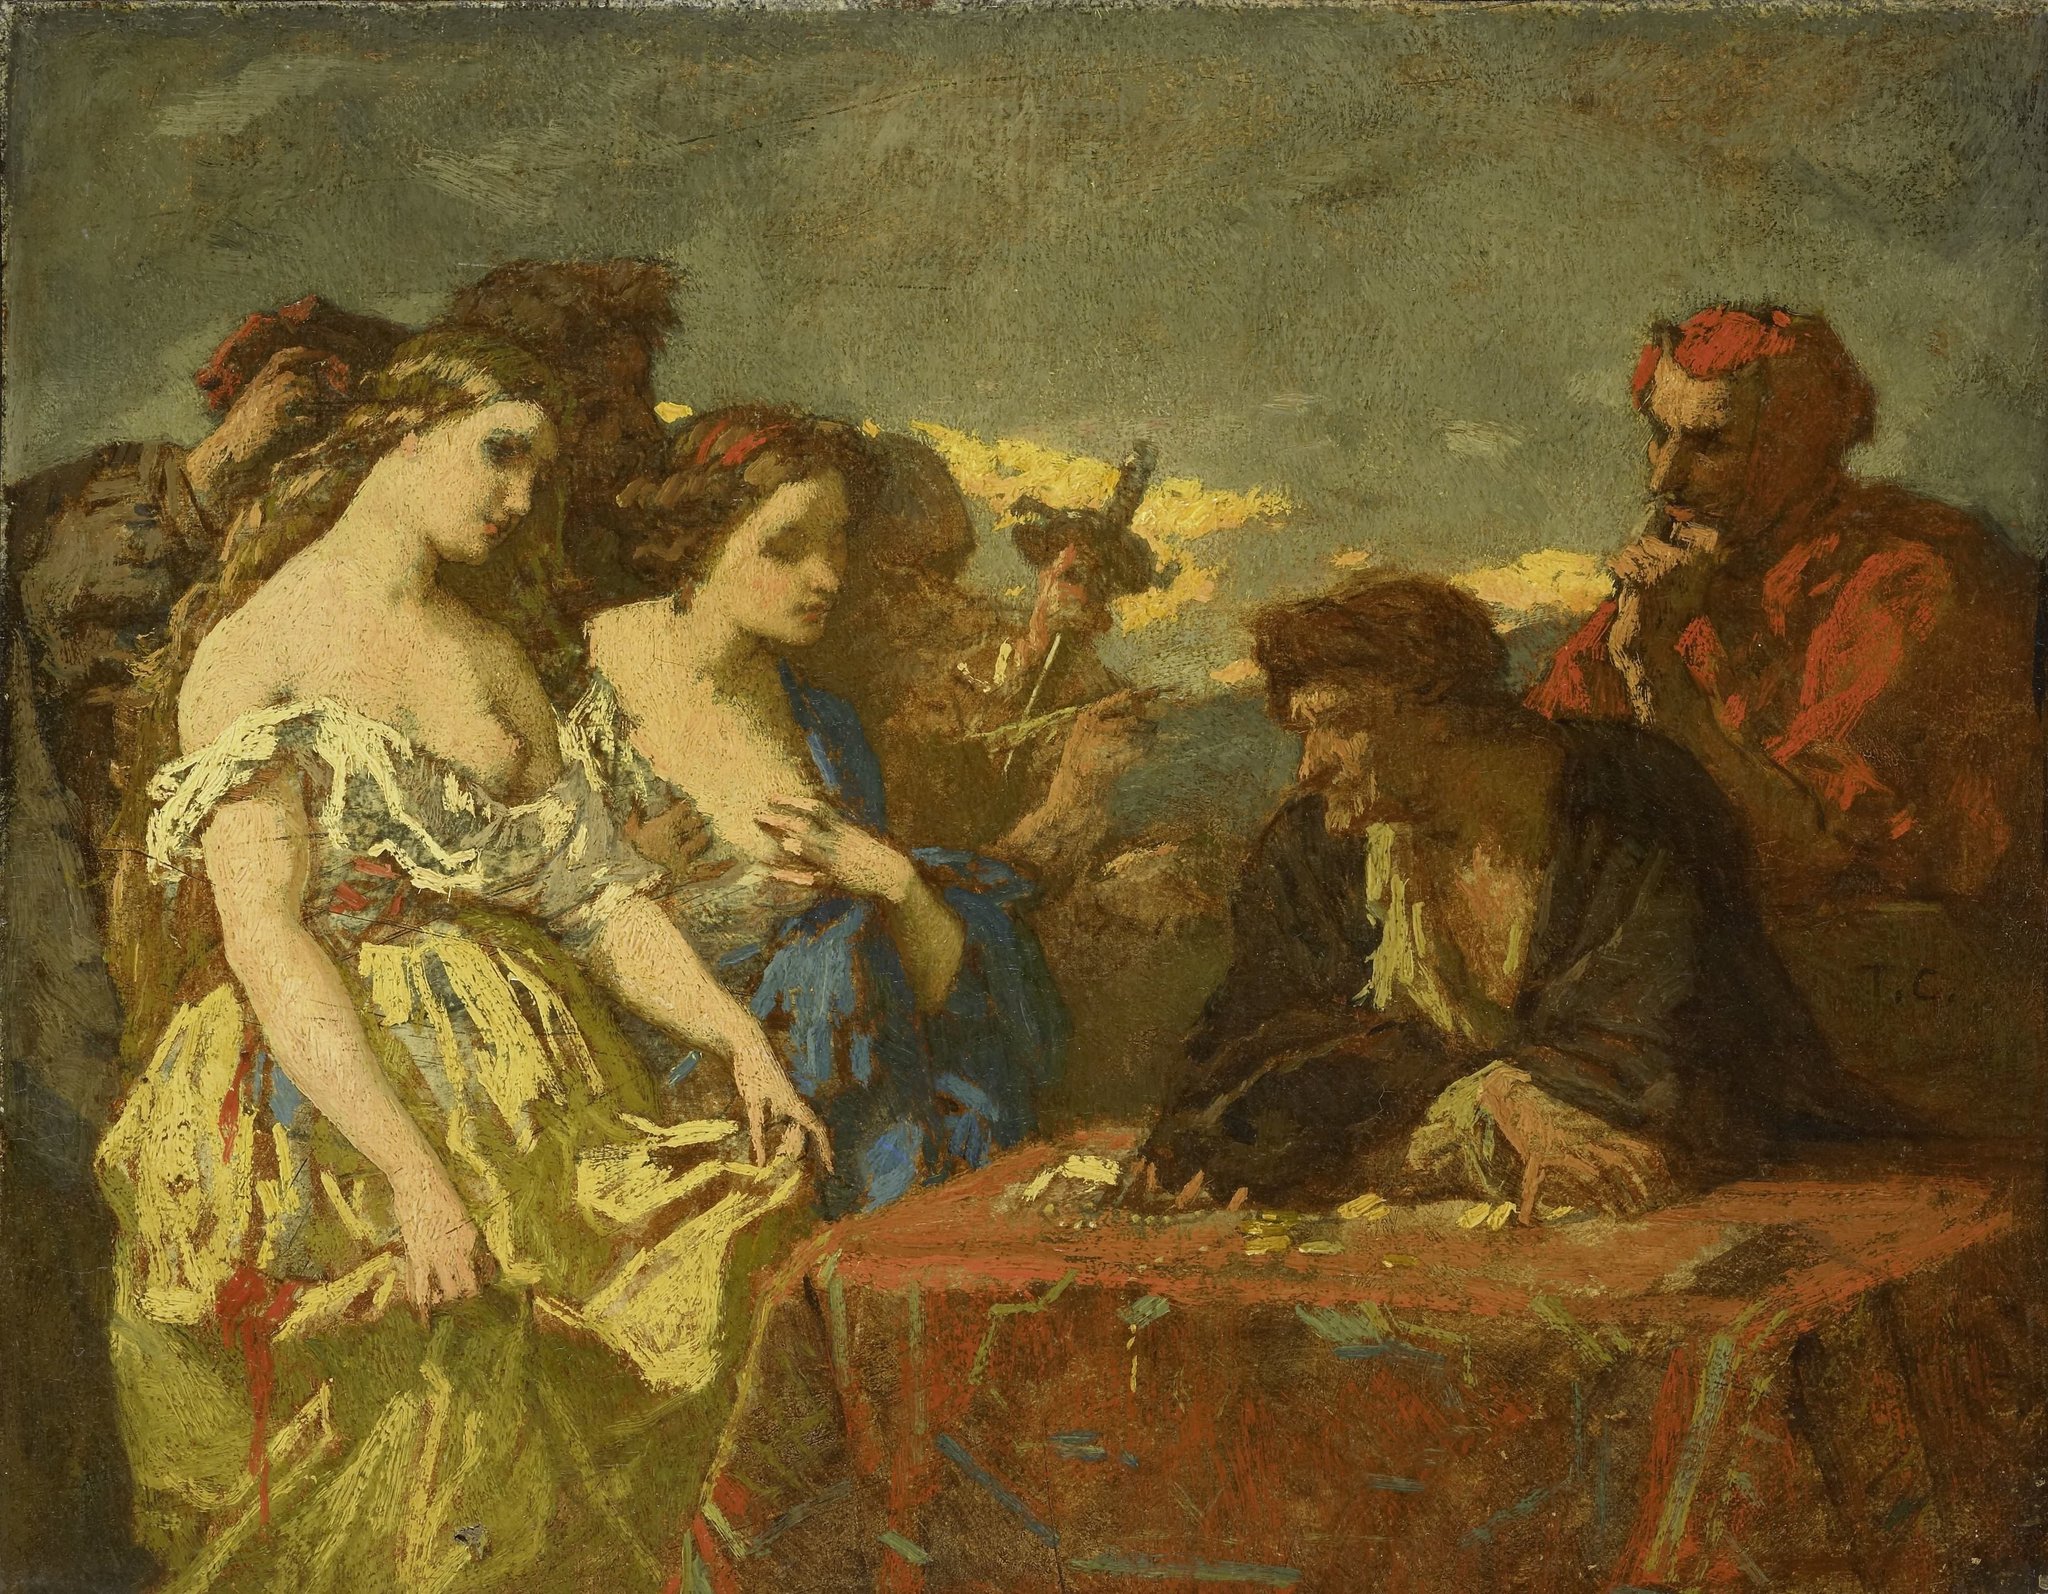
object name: painting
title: Lust for Gold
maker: thomas couture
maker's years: 1815-1879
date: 1840-1879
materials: canvas, oil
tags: money-changer, mephistopheles, name of the demonic tempter in the literary versions of the faust legends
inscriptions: signature: ‘T.C.’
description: De gouddorst. Jonge vrouwen met ontblote borsten staande bij een tafel waarachter zit een oude man met geld en sieraden. Achter de man staat een grijnzende Mefisto.